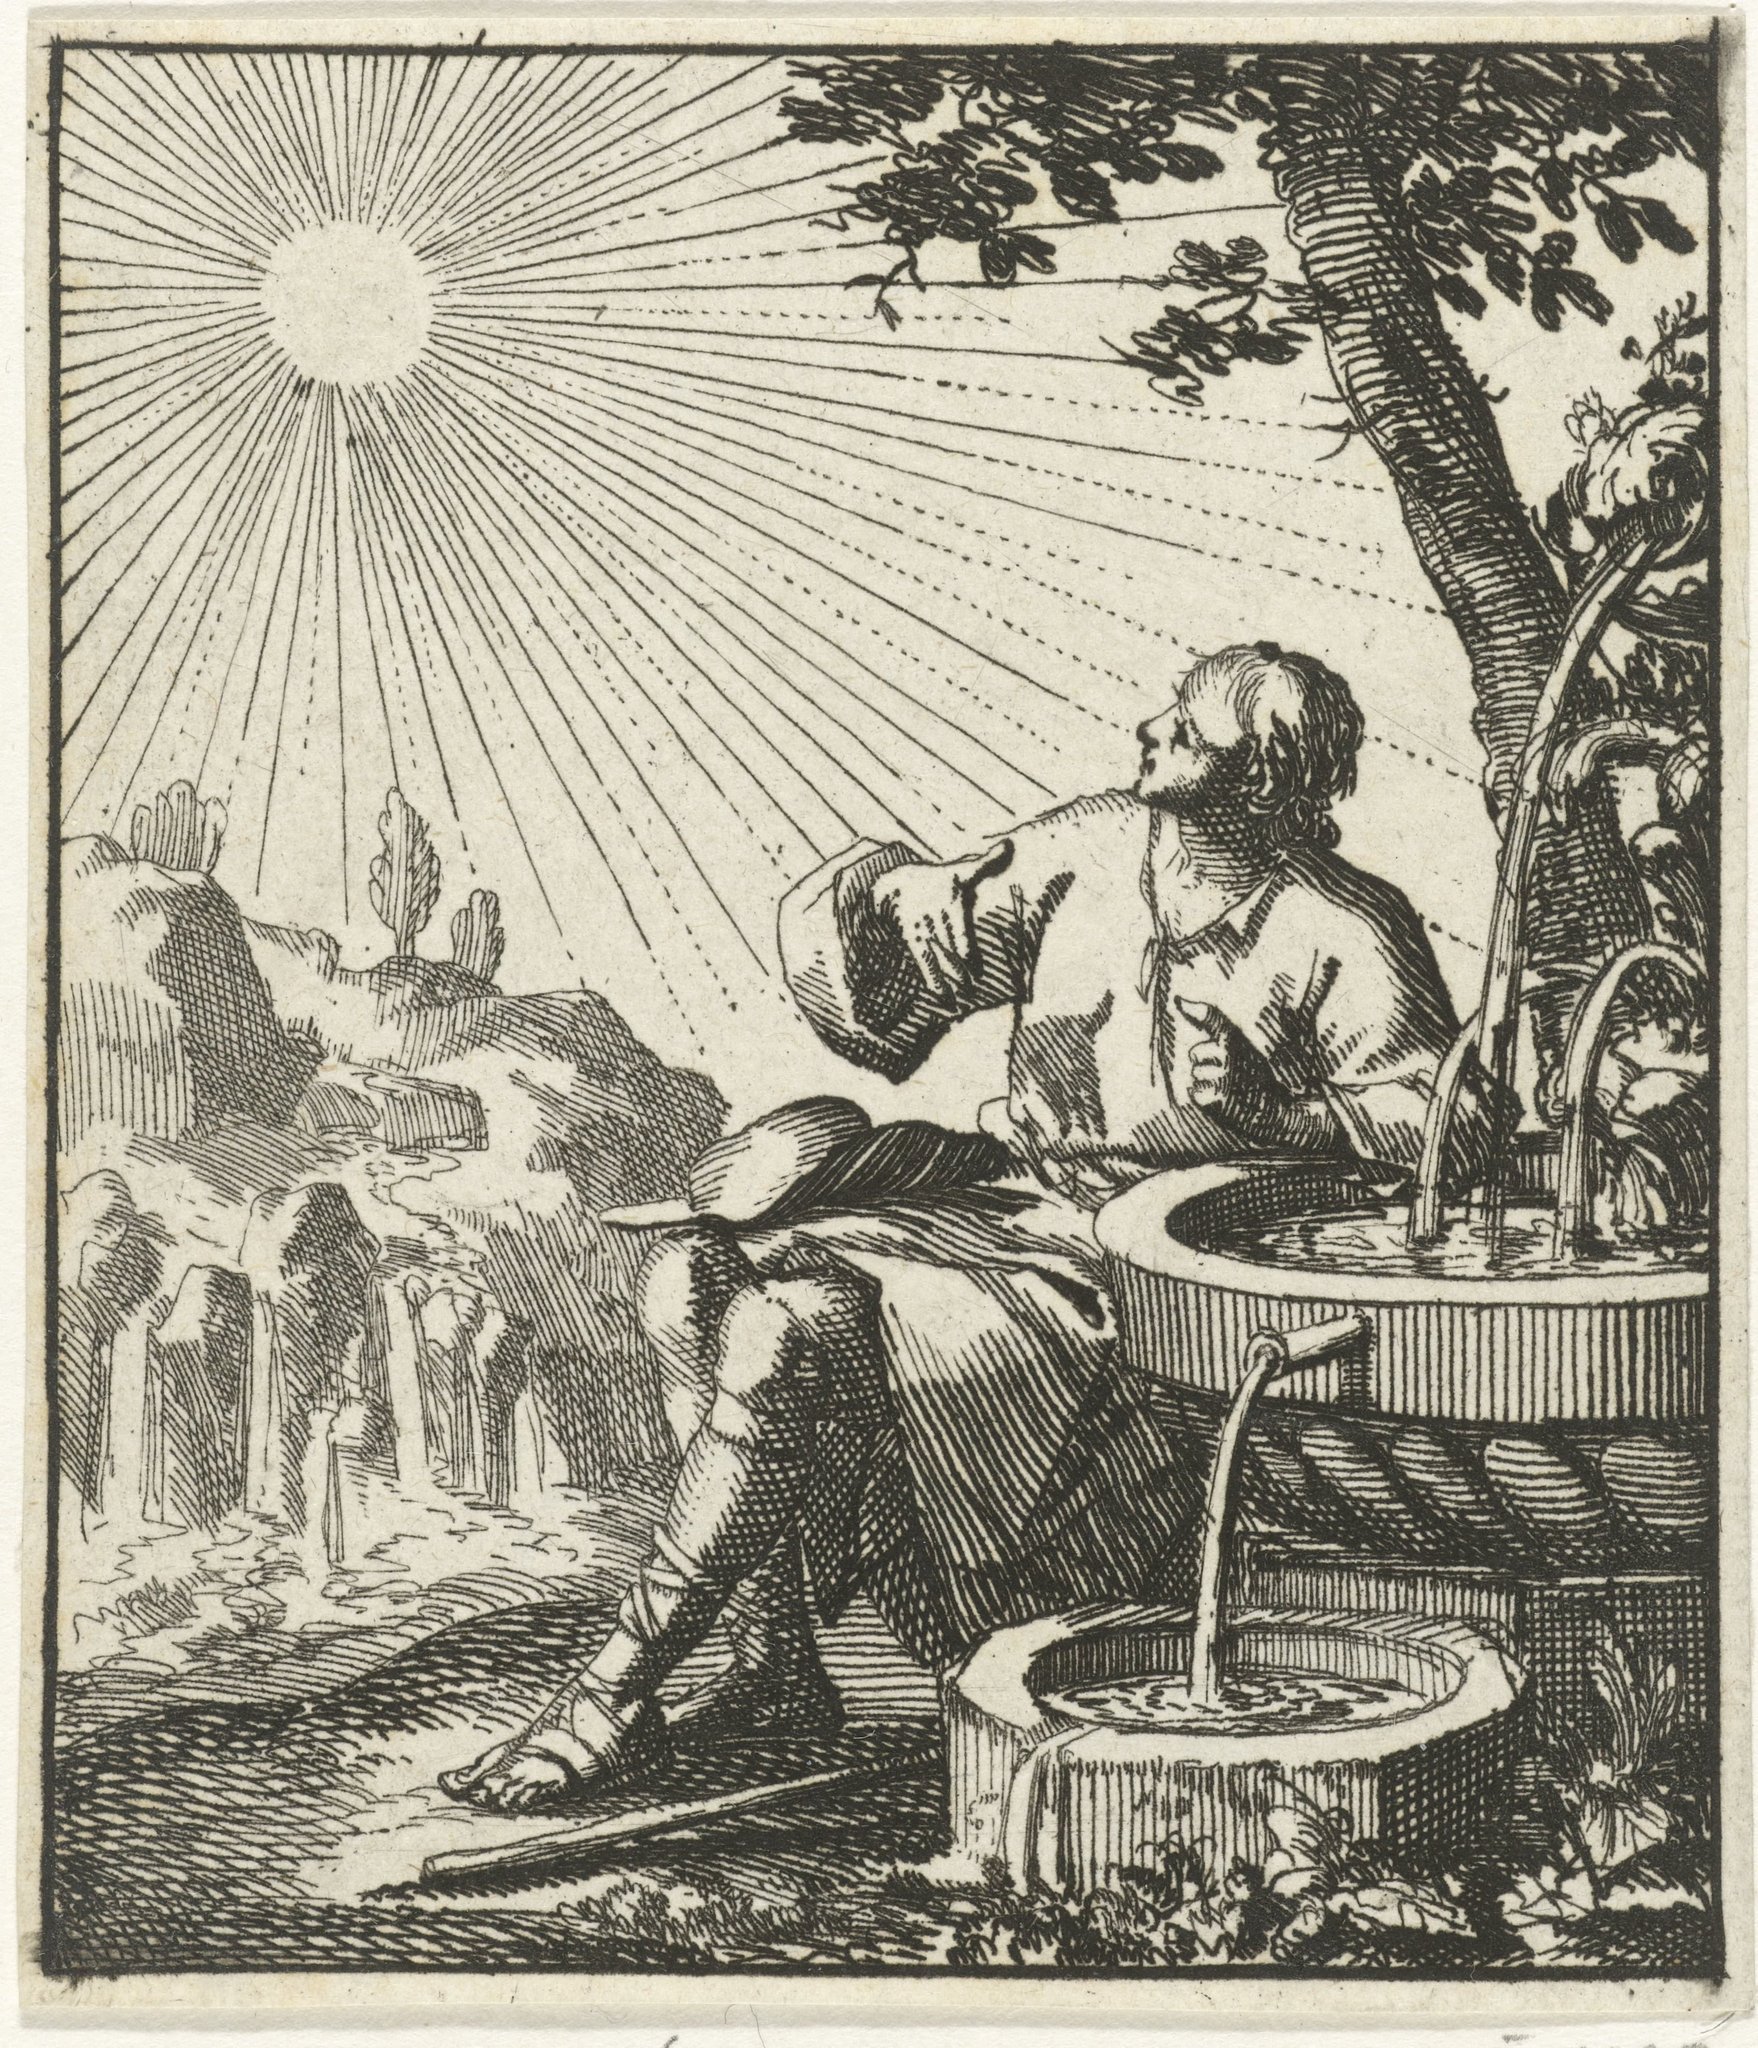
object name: book illustration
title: Man zittend naast een fontein, de zon aanschouwend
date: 1689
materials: paper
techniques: etching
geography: amsterdam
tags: garden fountain, sunlight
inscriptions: collector's mark: Lugt 2228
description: Illustratie uit: Huygen, Pieter. De beginselen van Gods koninkryk in den mensch uitgedrukt in zinnebeelden. Amsterdam: wed. Arentsz. Pieter (II), 1689, p. 110.